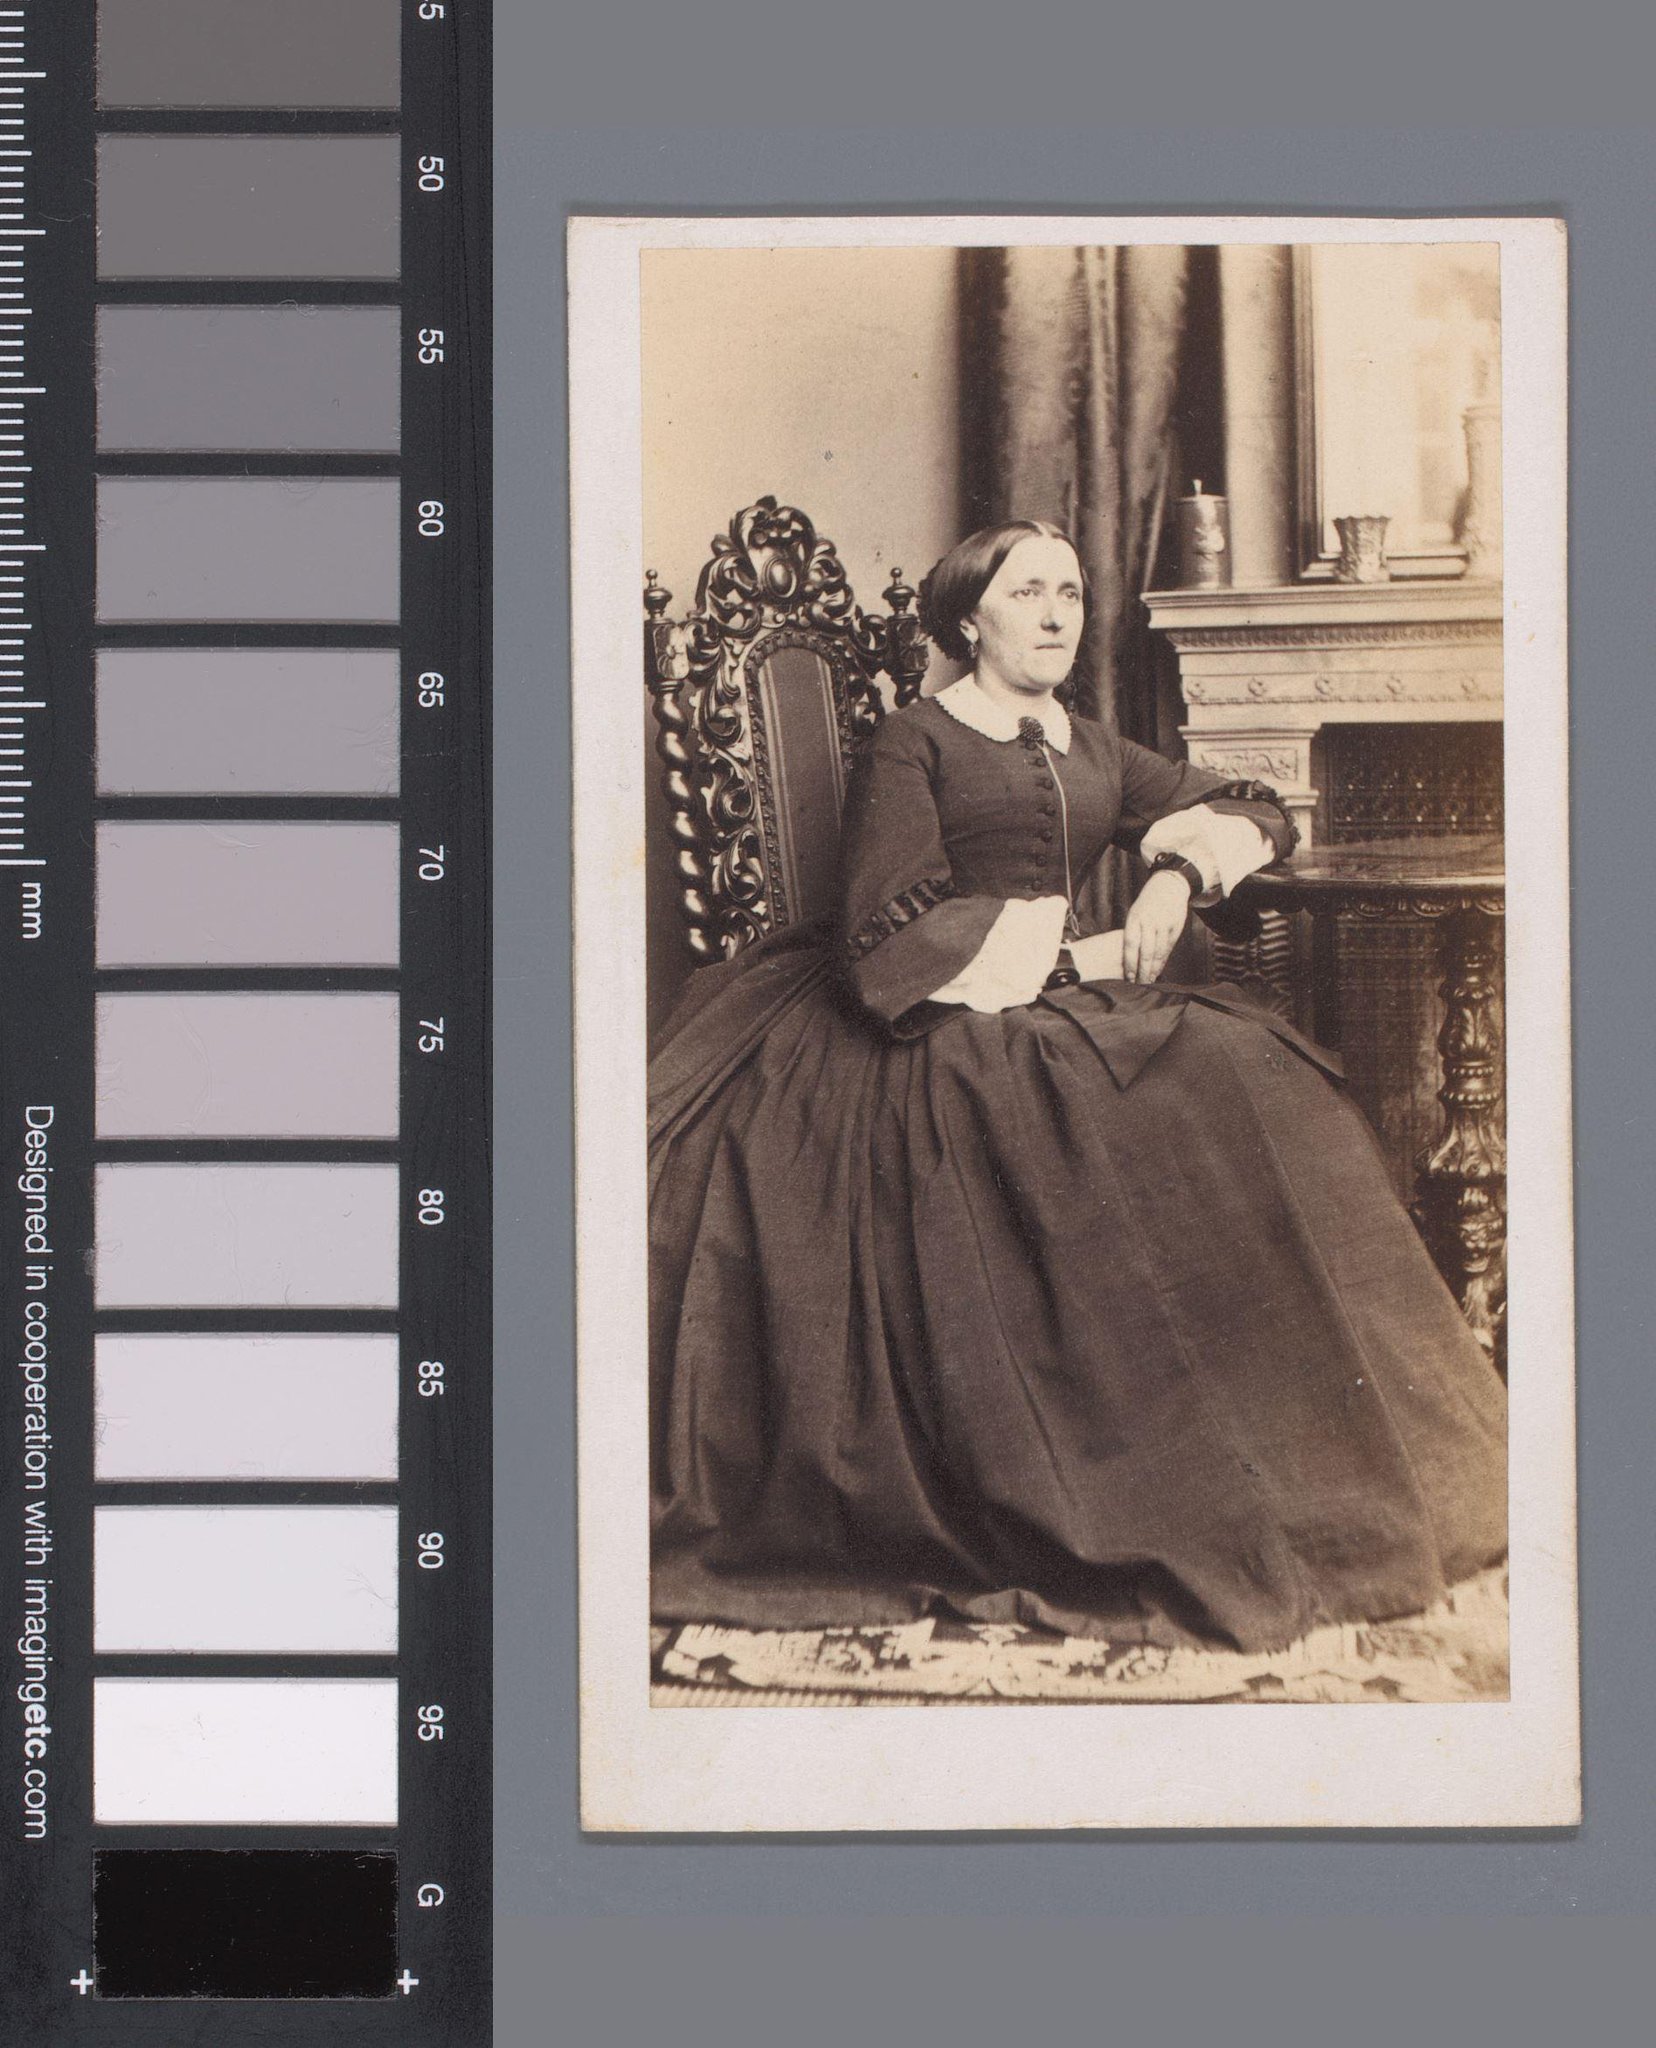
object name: photograph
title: Portret van een onbekende vrouw bij een tafel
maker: gustav schauer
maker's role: painter, publisher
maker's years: 1826-1902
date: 1851-1864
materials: cardboard, paper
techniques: albumen print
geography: berlin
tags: adult woman, anonymous historical person portrayed, berlin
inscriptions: inscription: ‘Gustav Schauer/ Photographisches Kunst- und Verlags-Institut/ Berlin/ Grosse Friedrichs-Strasse/ No. 188.’